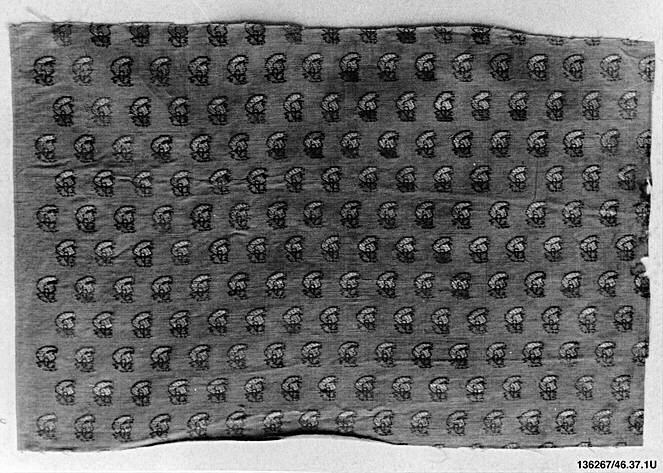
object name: textile fragment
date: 1701-1800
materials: metal thread, silk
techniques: brocade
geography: india